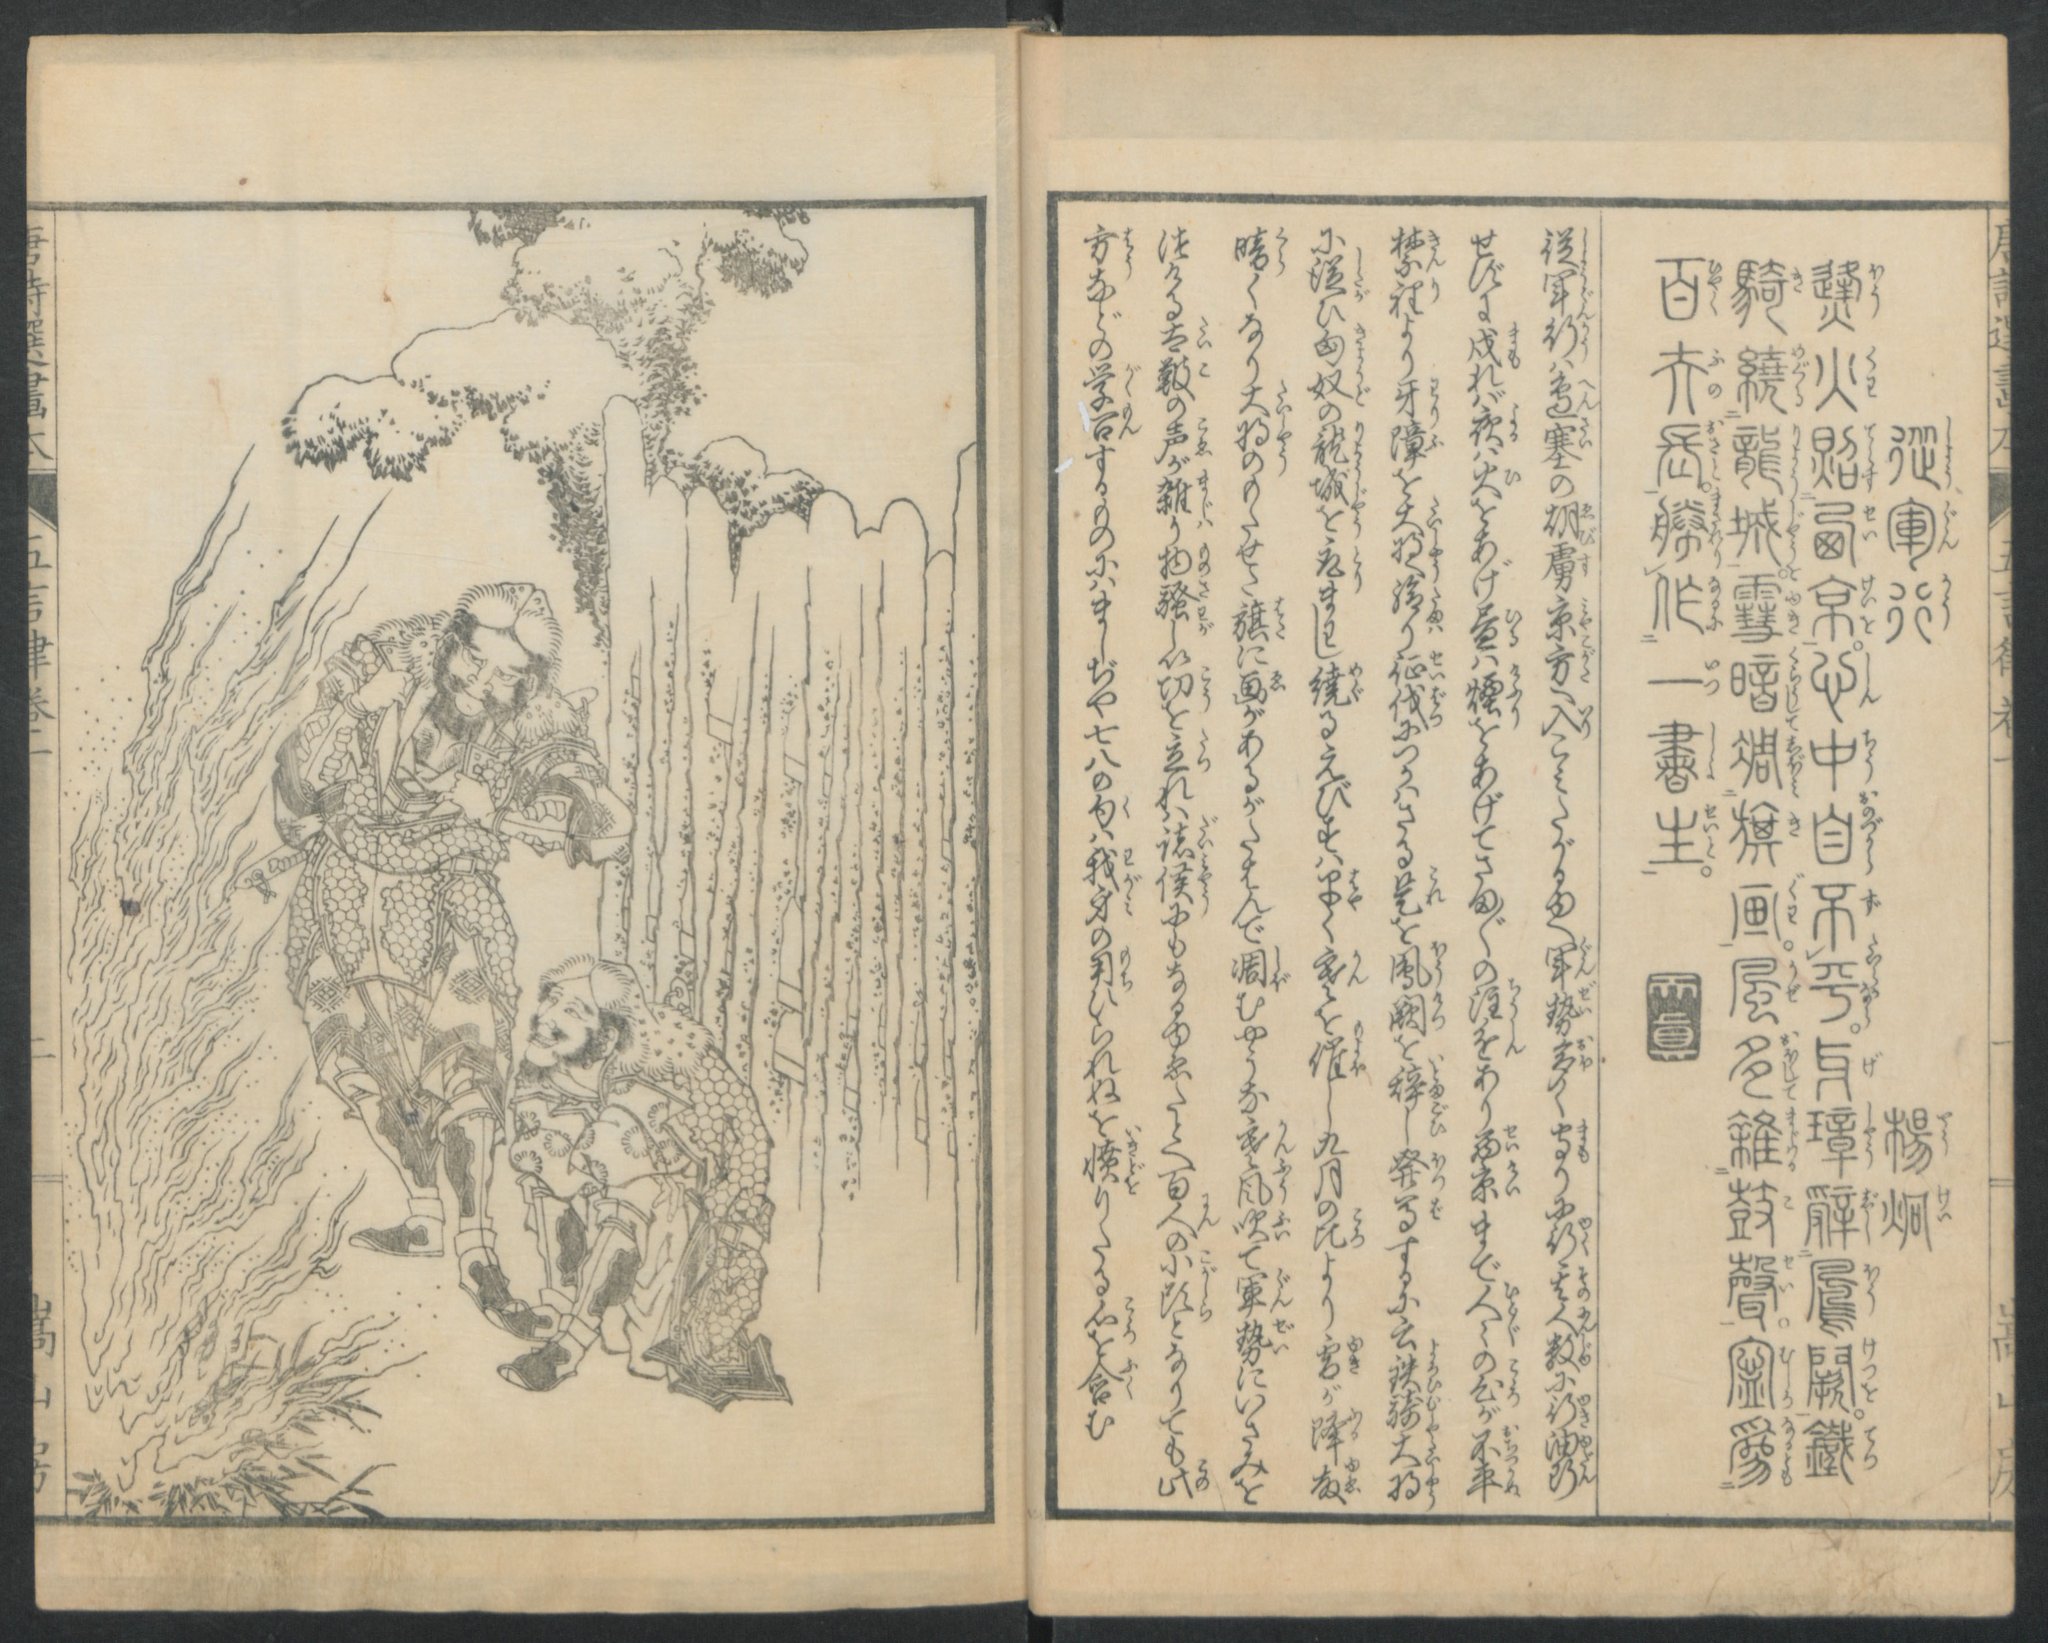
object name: illustrated book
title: Illustrations of Chinese Poems Chosen from Toshisen's Book (Tōshisen ehon) 唐詩撰畫本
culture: japanese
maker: katsushika hokusai 葛飾北斎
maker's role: artist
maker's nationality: japanese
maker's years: 1760-1849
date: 1833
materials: ink, paper